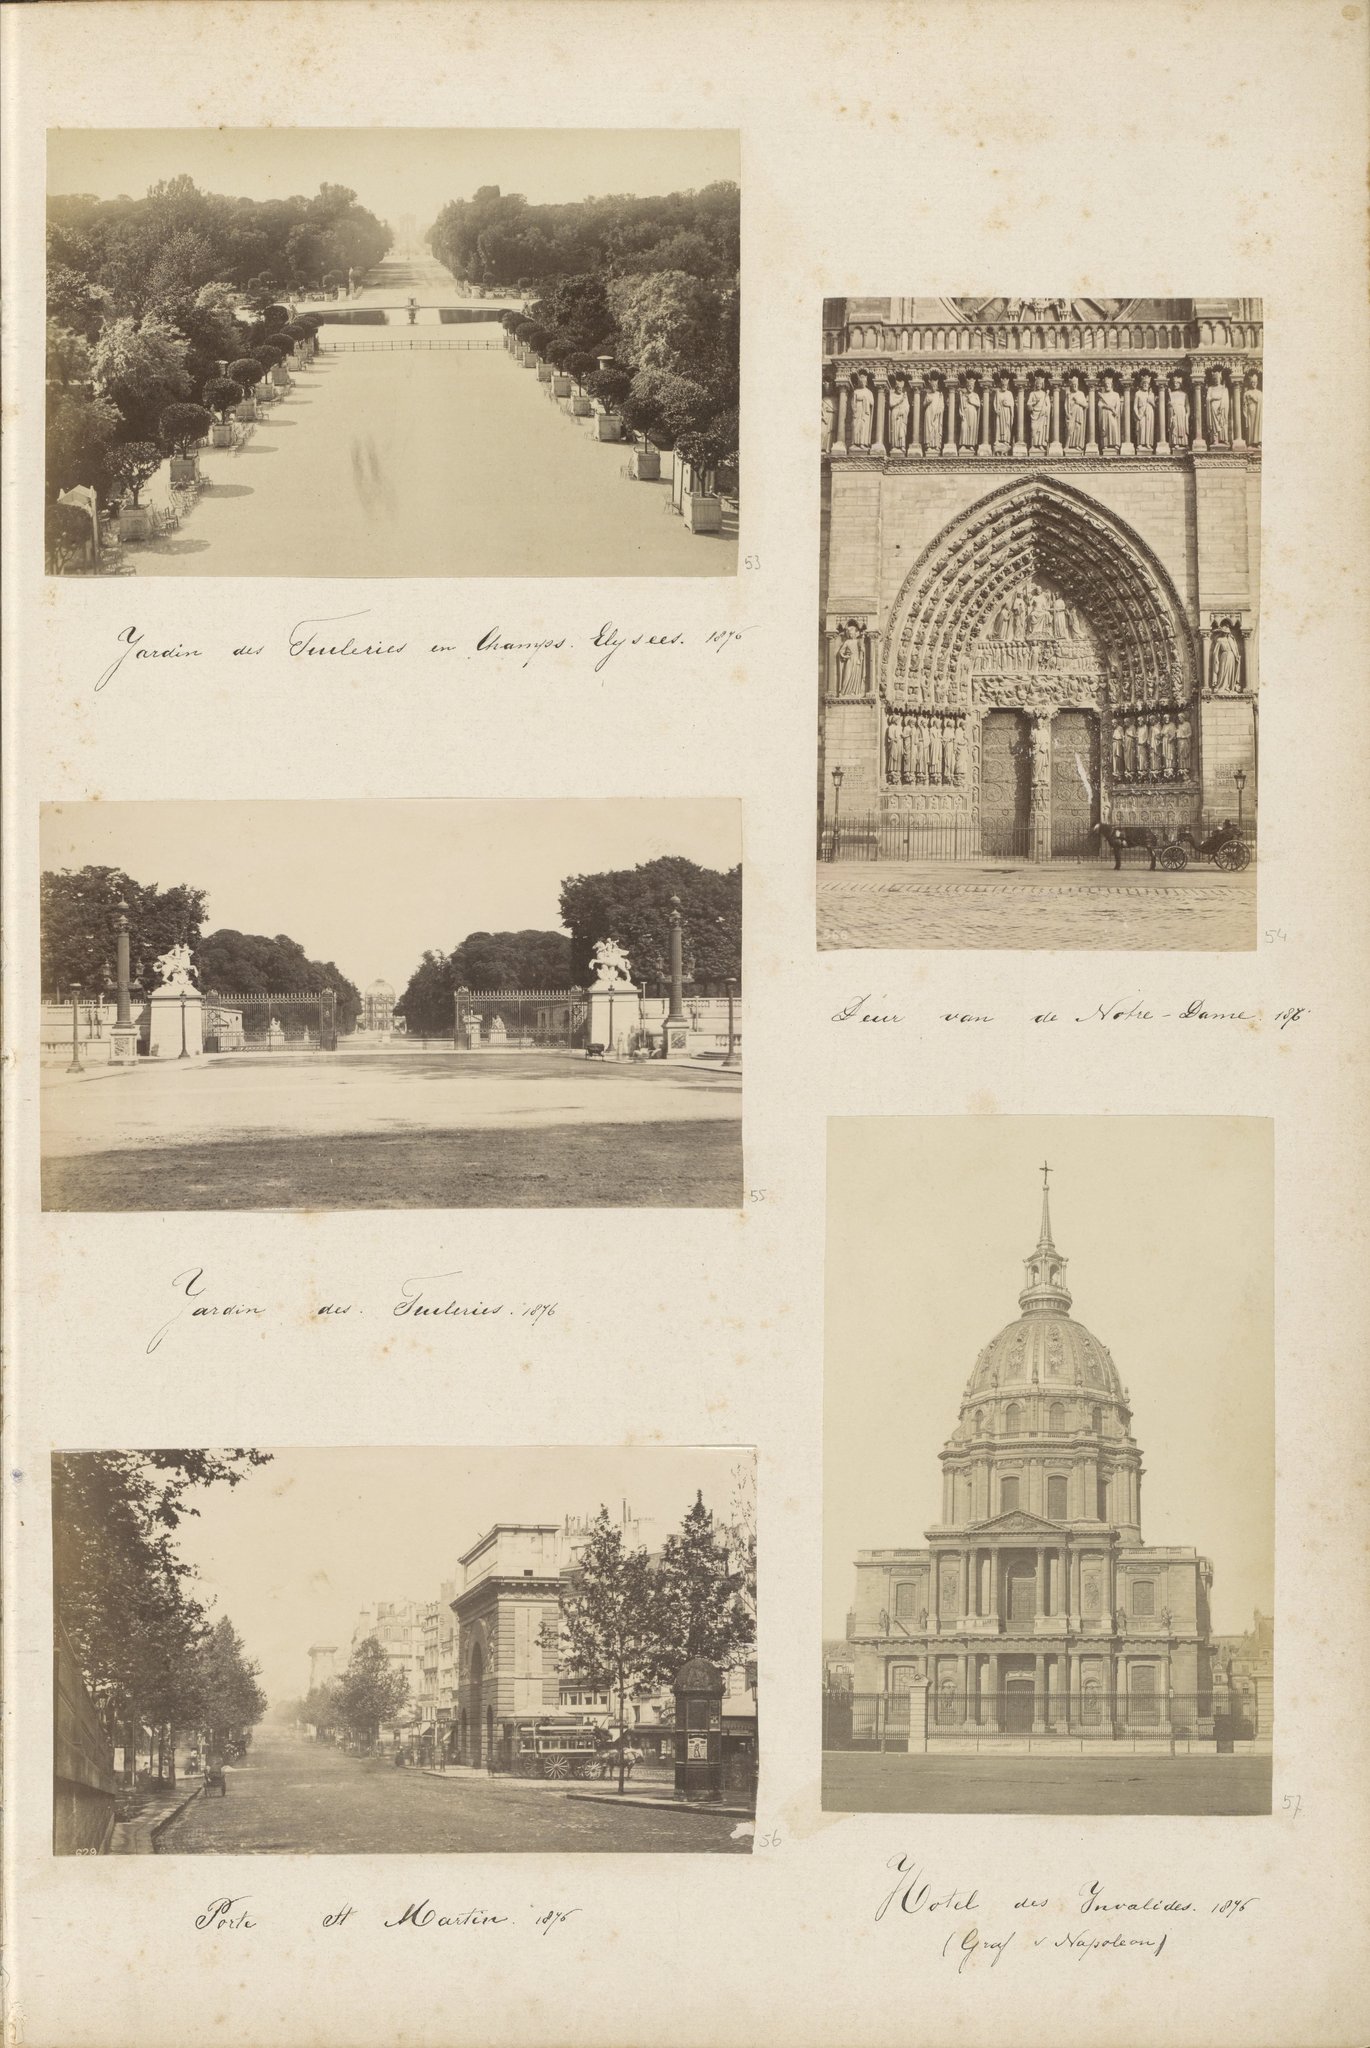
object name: photograph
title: Ingang van de Jardin des Tuileries in Parijs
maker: Anonymous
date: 1876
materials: paper, photographic support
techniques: albumen print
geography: paris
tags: fence, wall, paling, public gardens, park, paris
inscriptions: negative number: ‘566’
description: Onderdeel van Fotoalbum van Robert Daniel Crommelin (1841-1907).